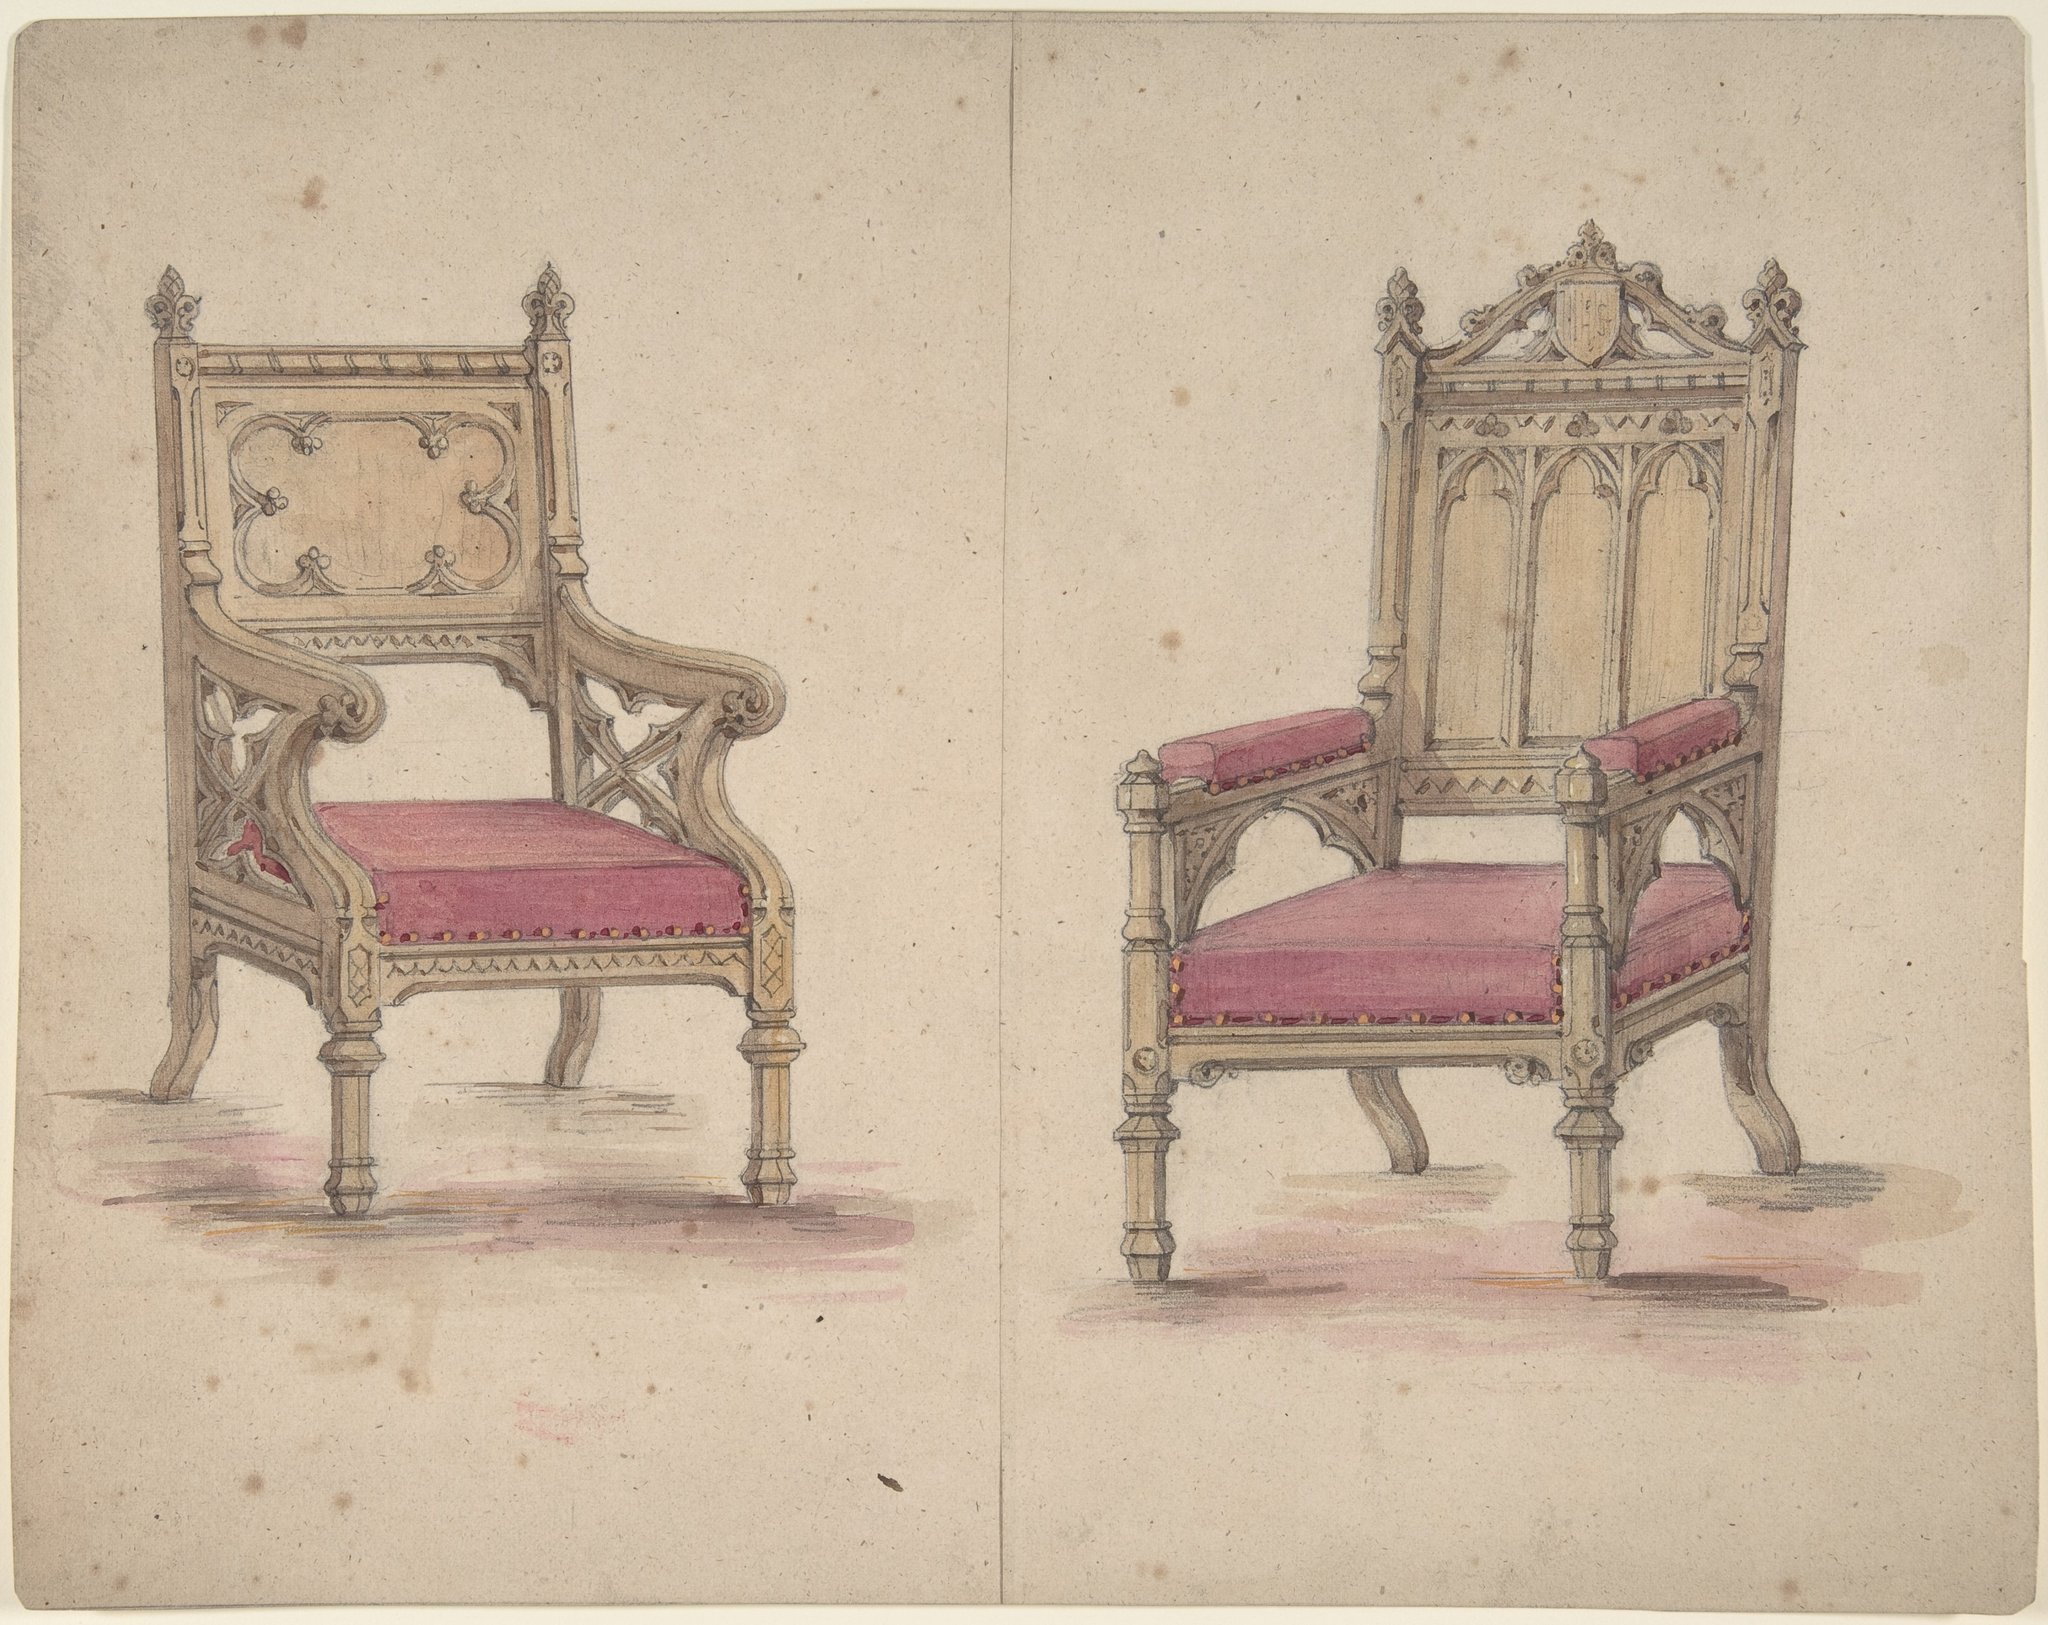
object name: drawing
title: Designs for Two Gothic Style Chairs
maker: anonymous, british, 19th century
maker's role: artist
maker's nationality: british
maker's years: 1800-1900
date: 1801-1900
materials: graphite, watercolor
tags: chairs